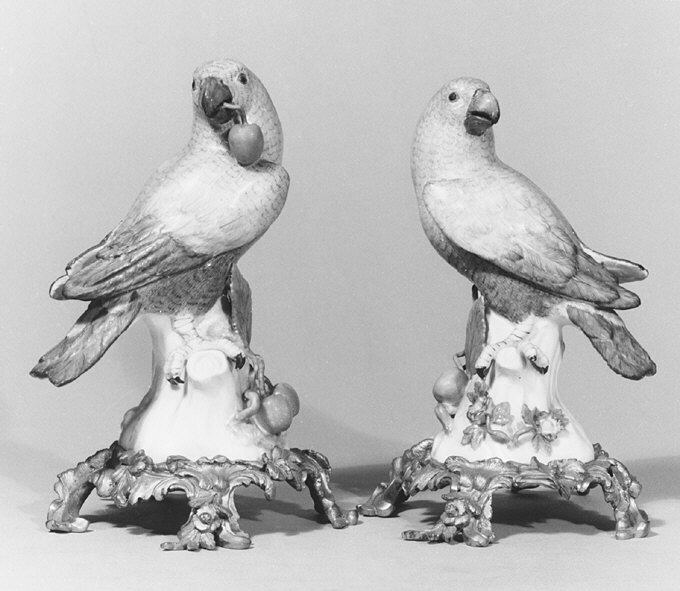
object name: figure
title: Parrot (one of a pair)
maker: meissen manufactory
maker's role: manufactory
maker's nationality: german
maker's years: 1710-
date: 1741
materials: gilt bronze, hard paste porcelain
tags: fruit,parrots,flowers